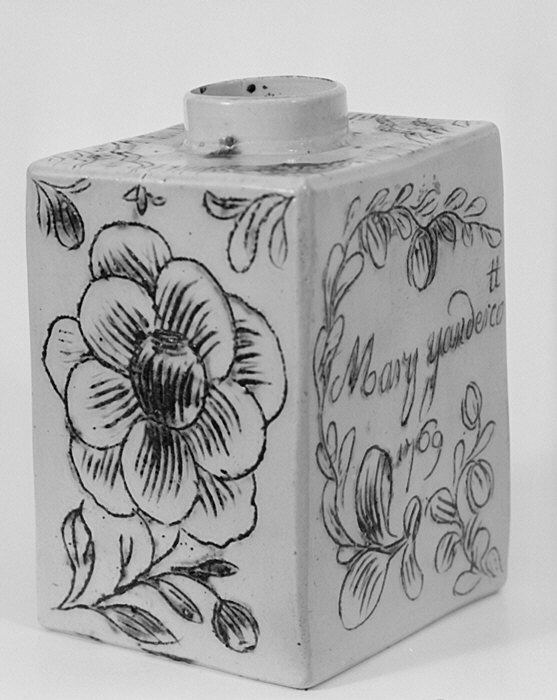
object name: tea caddy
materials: stoneware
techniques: salt glaze